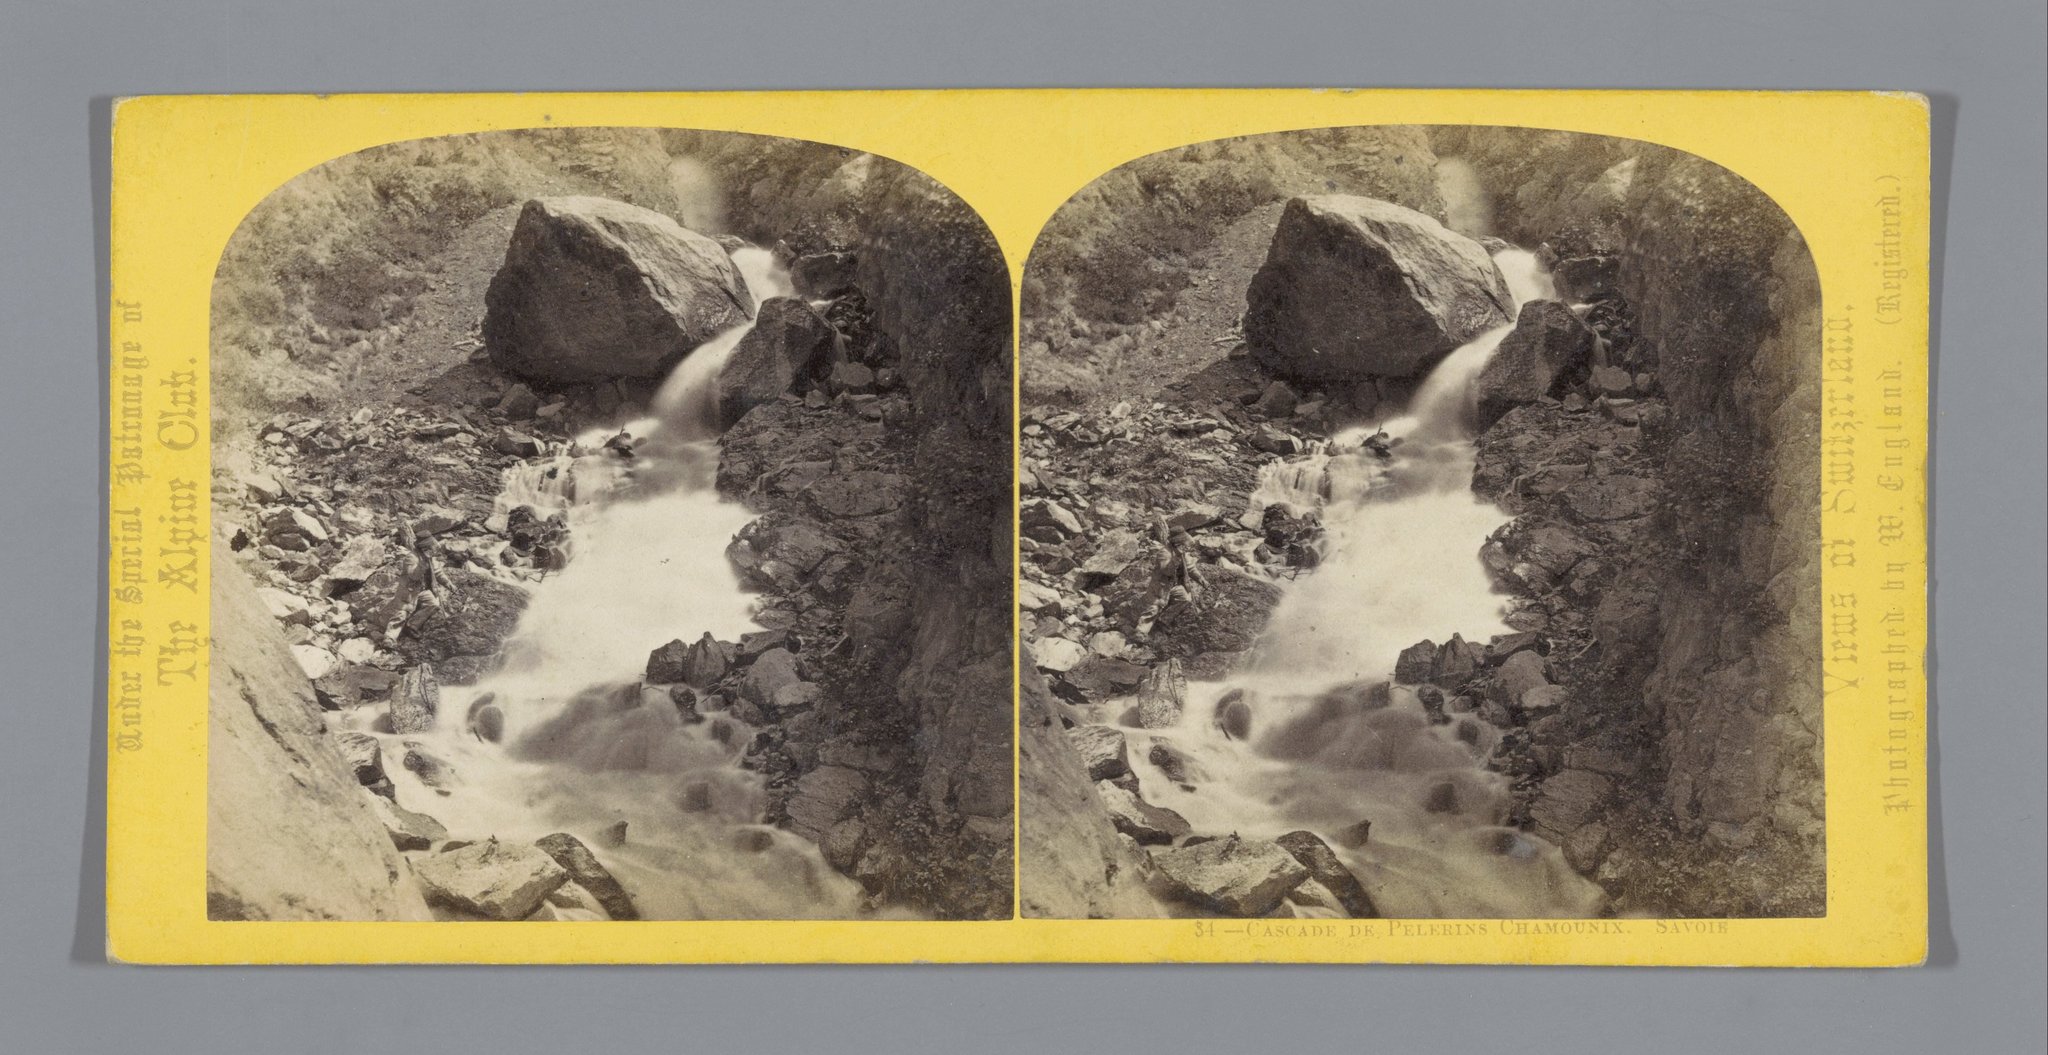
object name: stereograph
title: Cascade de Pelerins Chamounix. Savoie.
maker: william england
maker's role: fotograaf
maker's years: 1816-1896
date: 1850-1880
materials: cardboard, photographic support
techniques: albumen print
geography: bonneville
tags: waterfall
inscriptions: number: ‘34’, inscription: ‘Views of Switzerland, photographed by W. England. (Registered) Under the Special Patronage of the Alpine Club.’